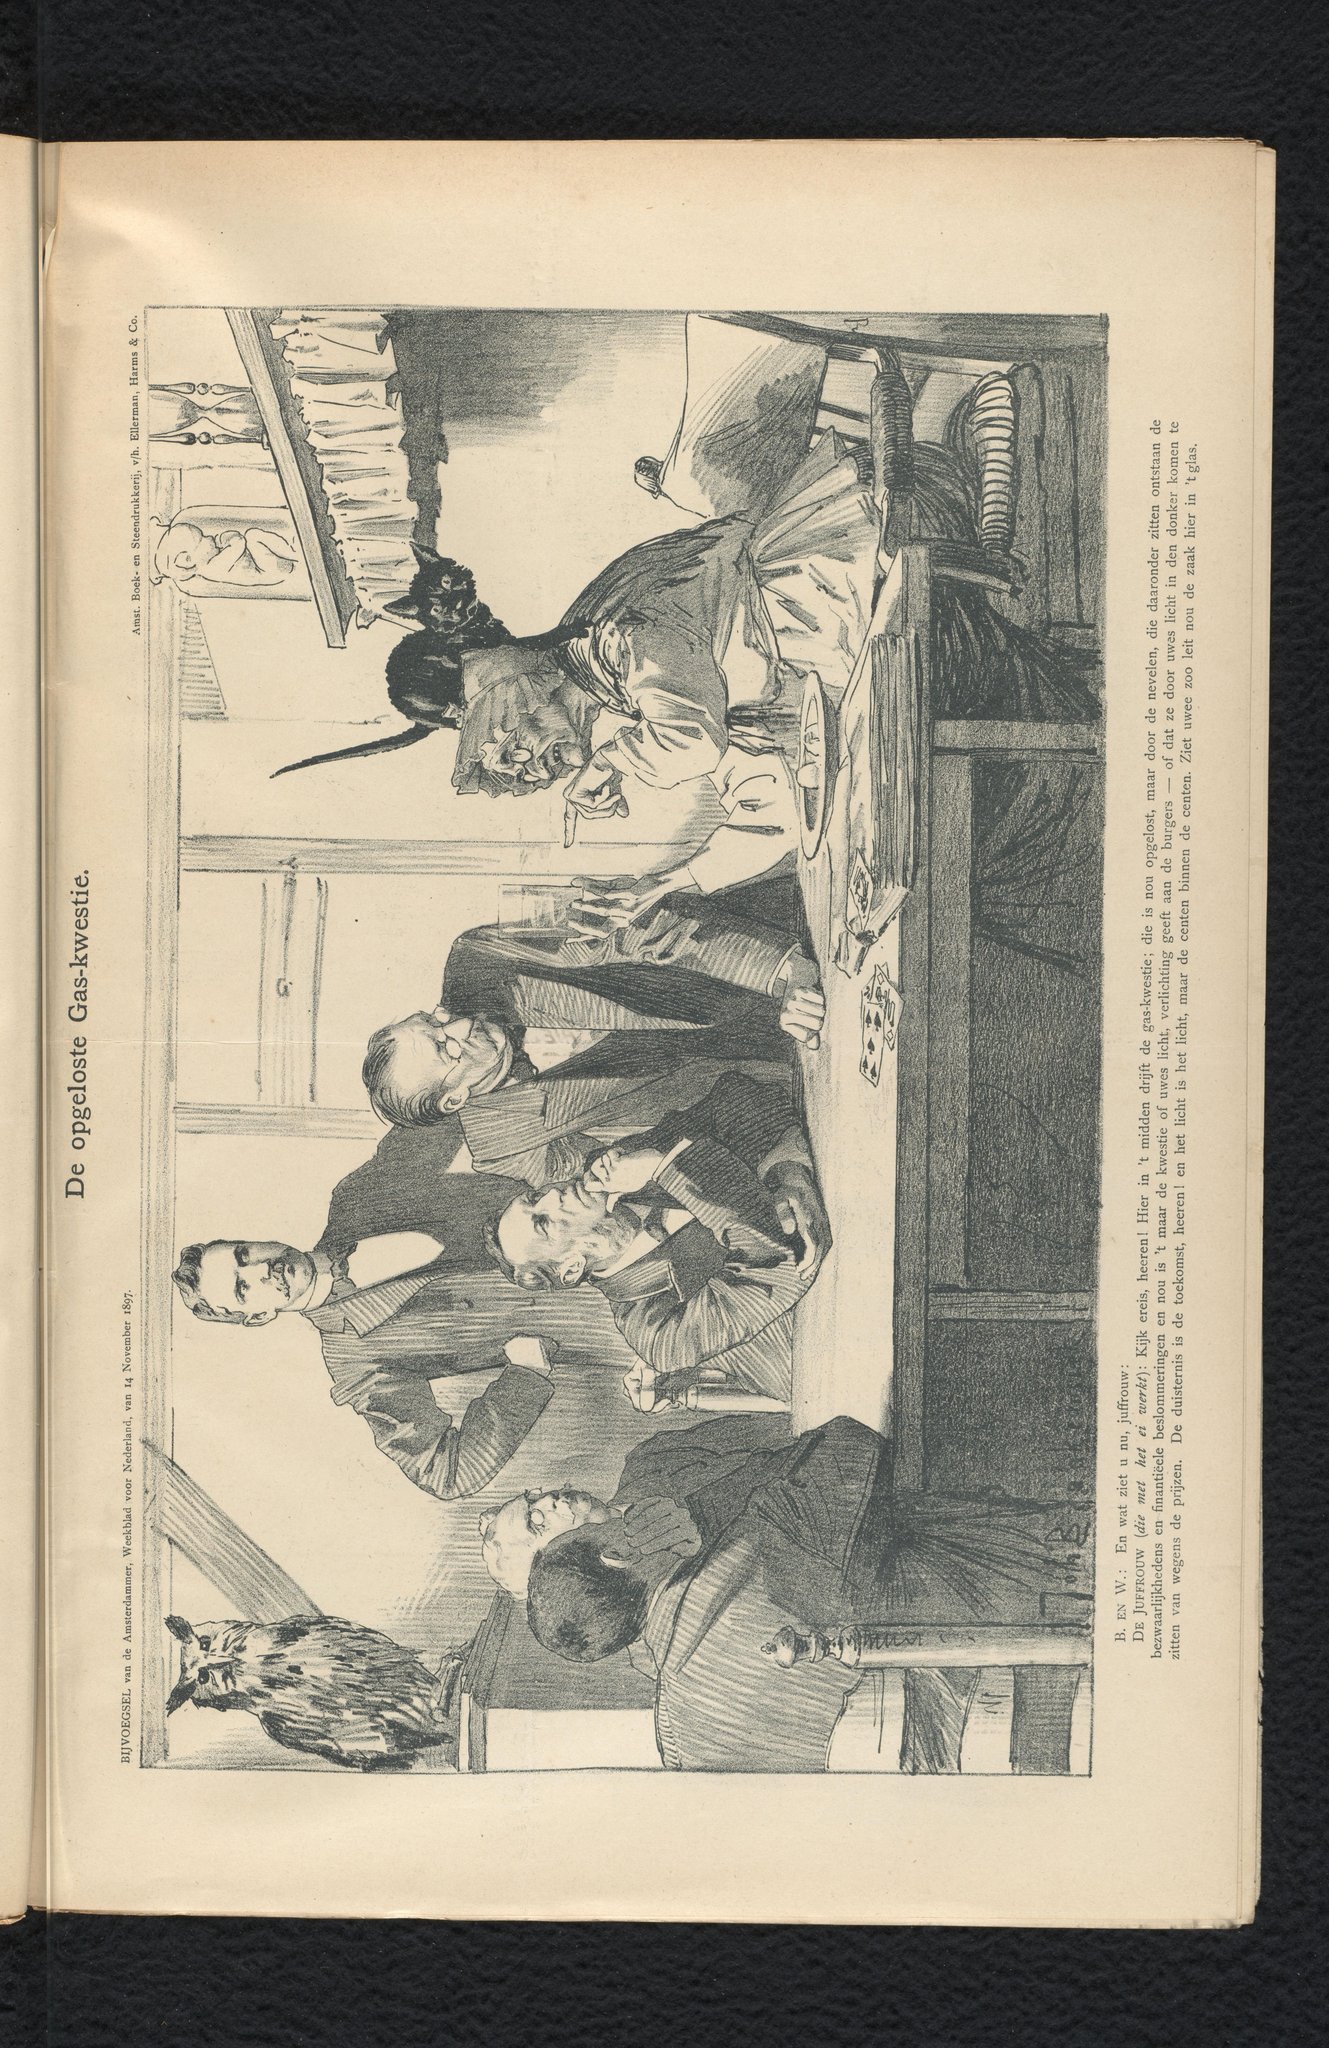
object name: cartoon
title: De opgeloste Gas-kwestie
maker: johan braakensiek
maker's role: draughtsman, print maker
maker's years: 1858-1940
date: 1897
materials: paper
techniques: lithograph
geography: amsterdam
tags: cat, gas supply, witch, sorceress, divination with the aid of cards, municipal government, political caricatures and satires, amsterdam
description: Burgemeester en wethouders van Amsterdam raadplegen een oude vrouw (waarzegster - heks - kwakzalver) over de problemen met de gasvoorziening van de stad.